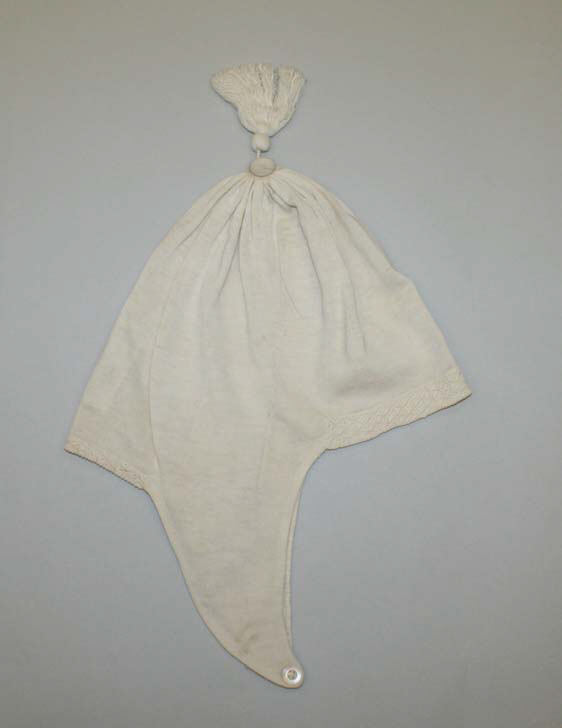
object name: cap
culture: american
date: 1801-1900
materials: cotton